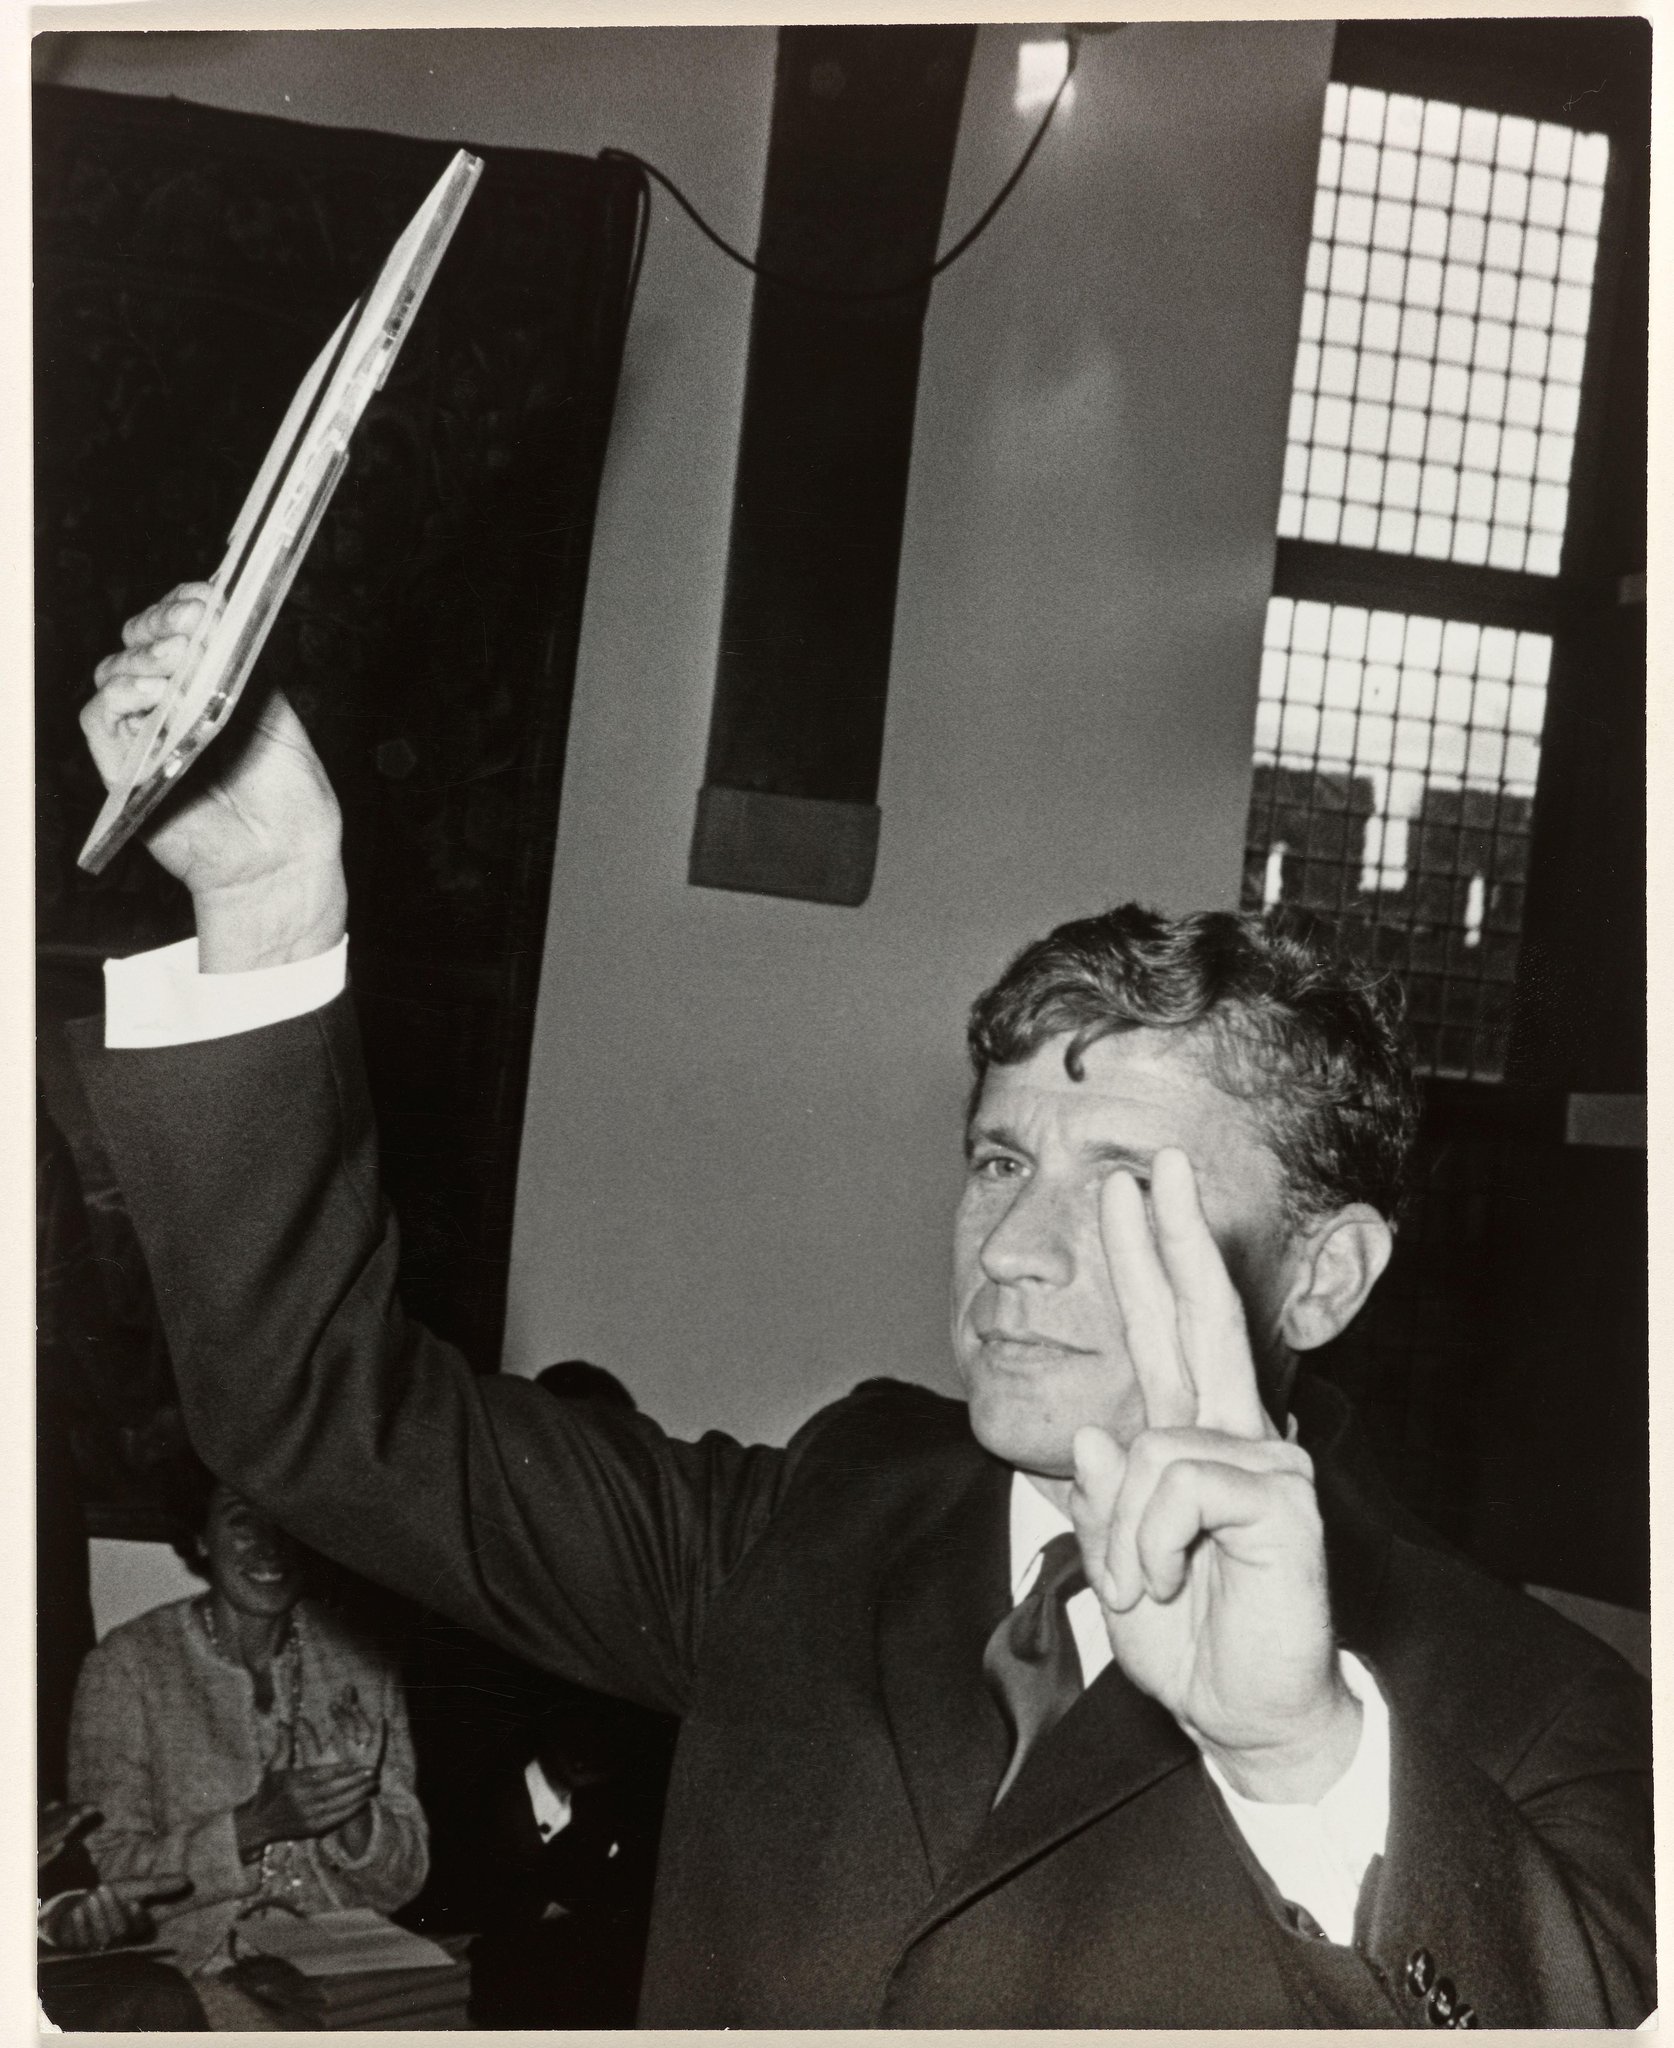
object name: photograph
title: Gerard Reve, uitreiking P.C. Hooftprijs, Muiderslot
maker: joost evers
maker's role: fotograaf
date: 1969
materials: paper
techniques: gelatin silver print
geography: netherlands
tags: amsterdam, portrait of a writer